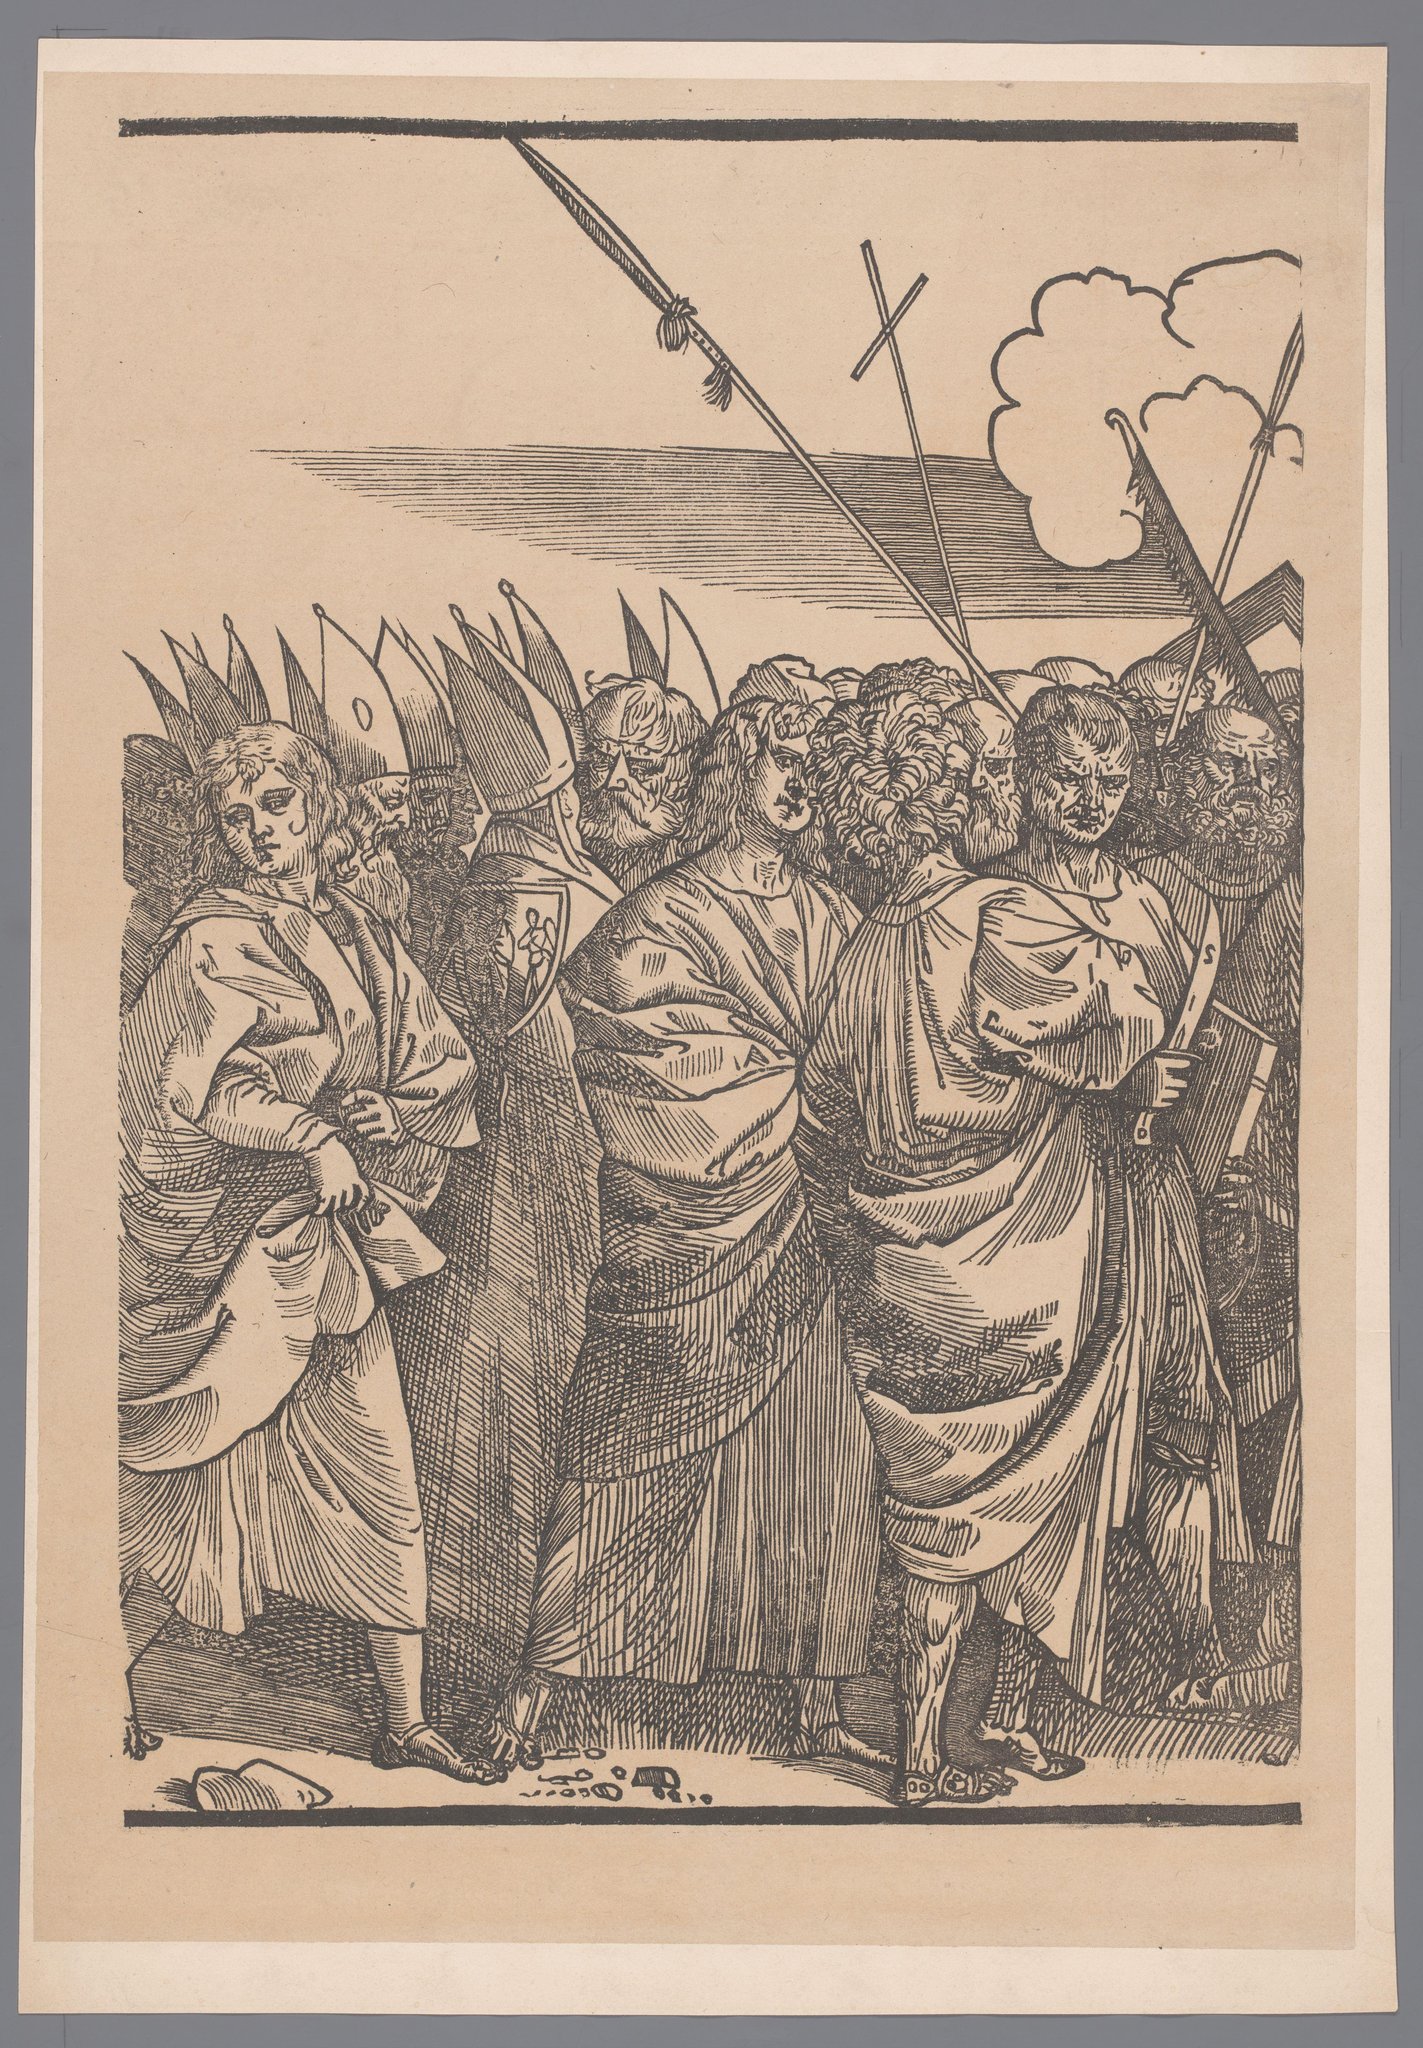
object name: reproduction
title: Reproductie van het derde deel van de prentreeks De Triomf van Christus naar Joos Lambrecht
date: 1857-1875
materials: paper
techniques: photolithograph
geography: belgium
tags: print, e.g.: engraving, etching, lithograph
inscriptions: inscription: ‘Nederlandsche Houtsneden 1500-1550 pl. 139/ M. Nijhoff/ De triompf van Christus, Gent 1543/ (1-10) pl. 3’, stamp: ‘R: MVS’